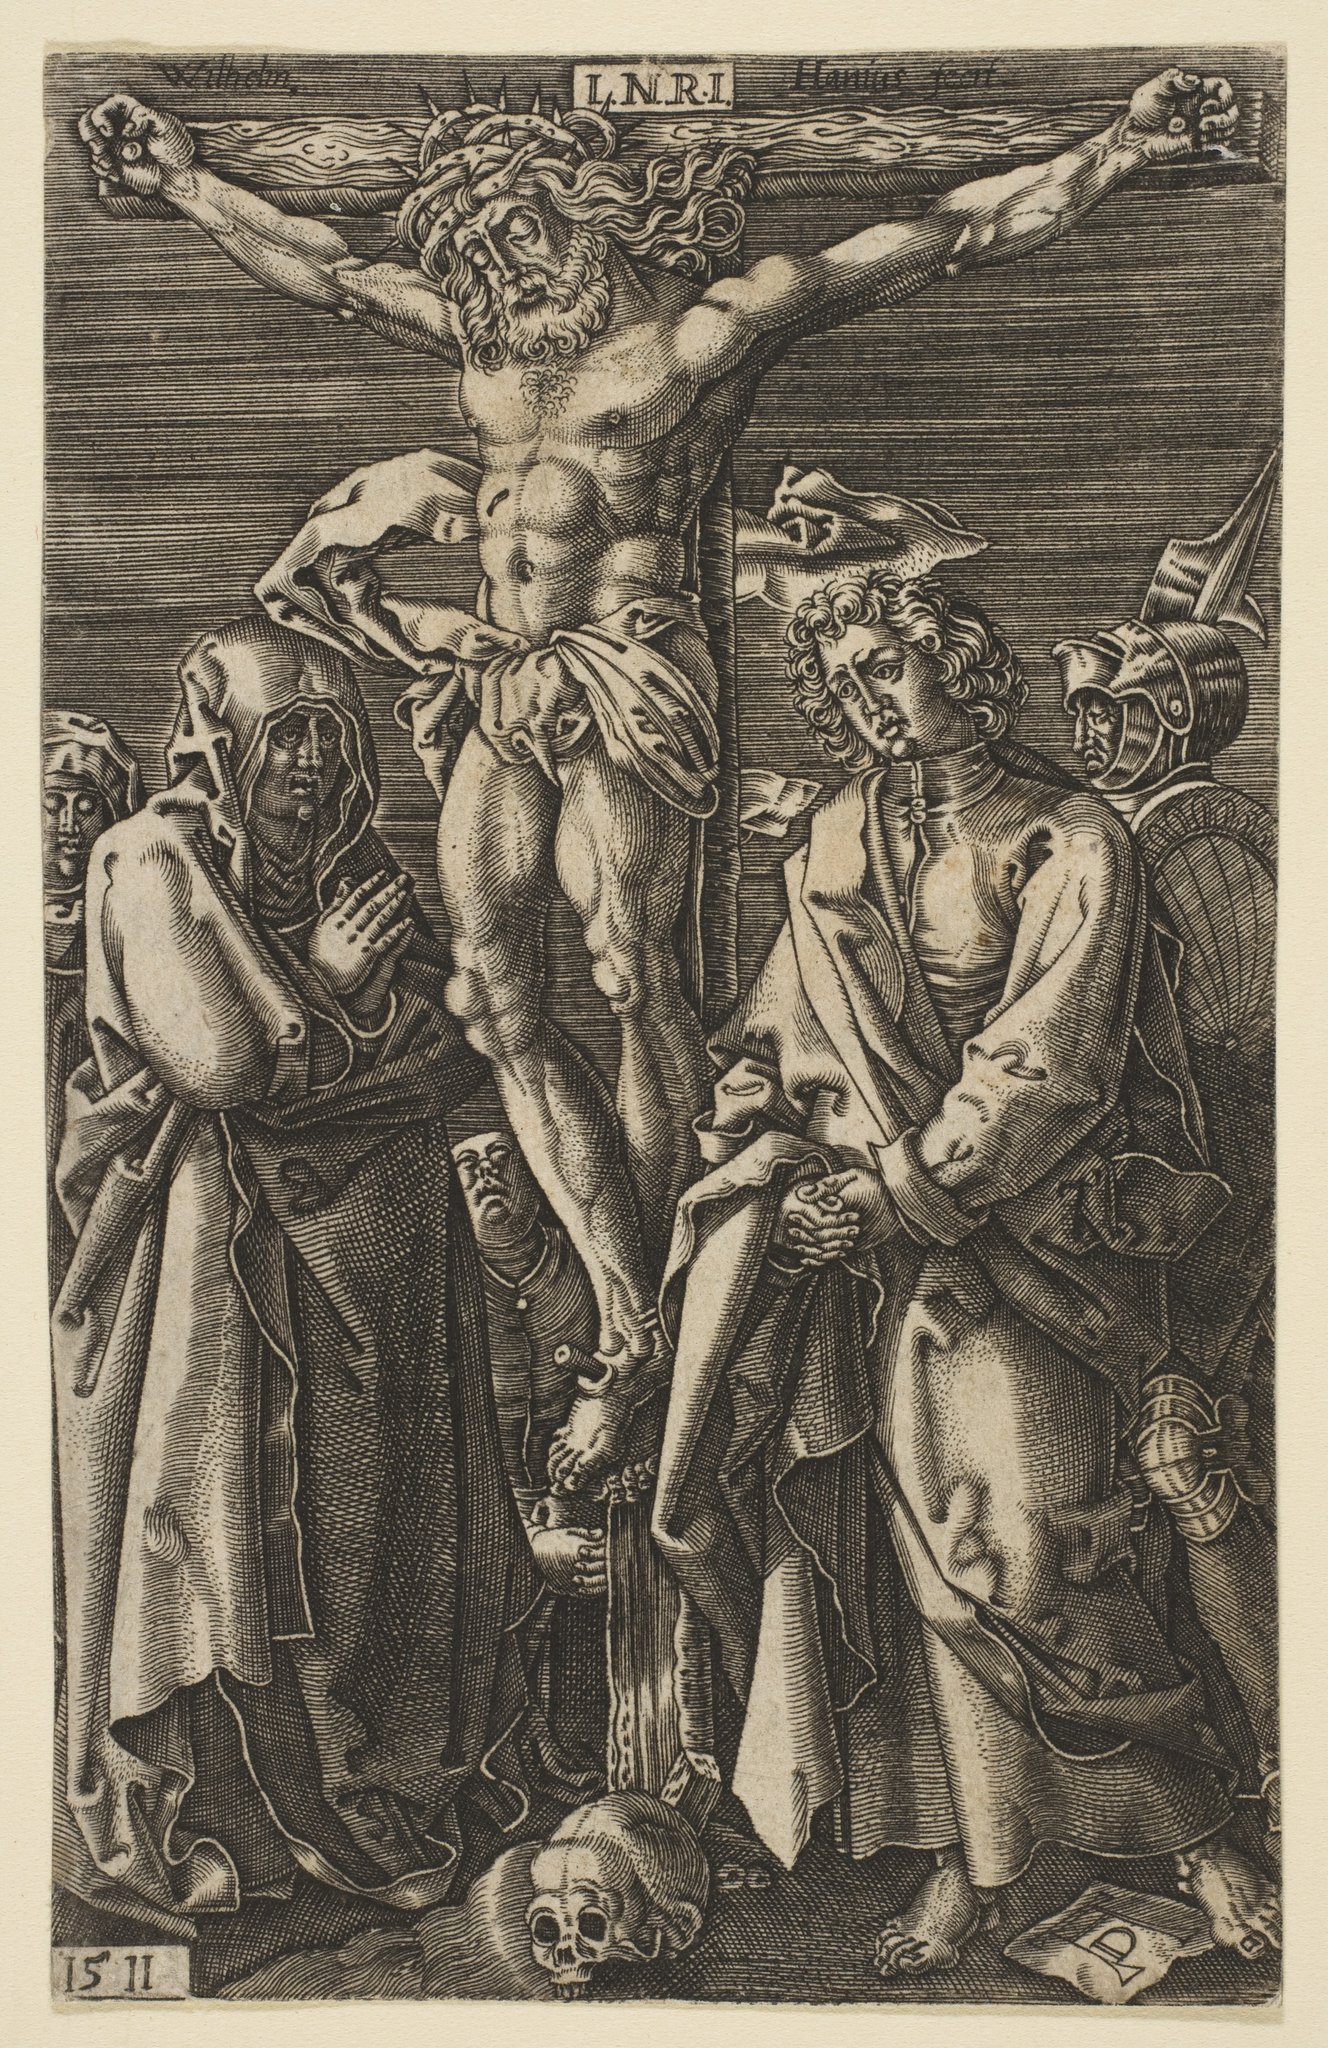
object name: print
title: The Crucifixion, from The Passion (copy)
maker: albrecht dürer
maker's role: artist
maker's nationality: german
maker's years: 1471-1528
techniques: engraving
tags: men,women,christ,crucifixion